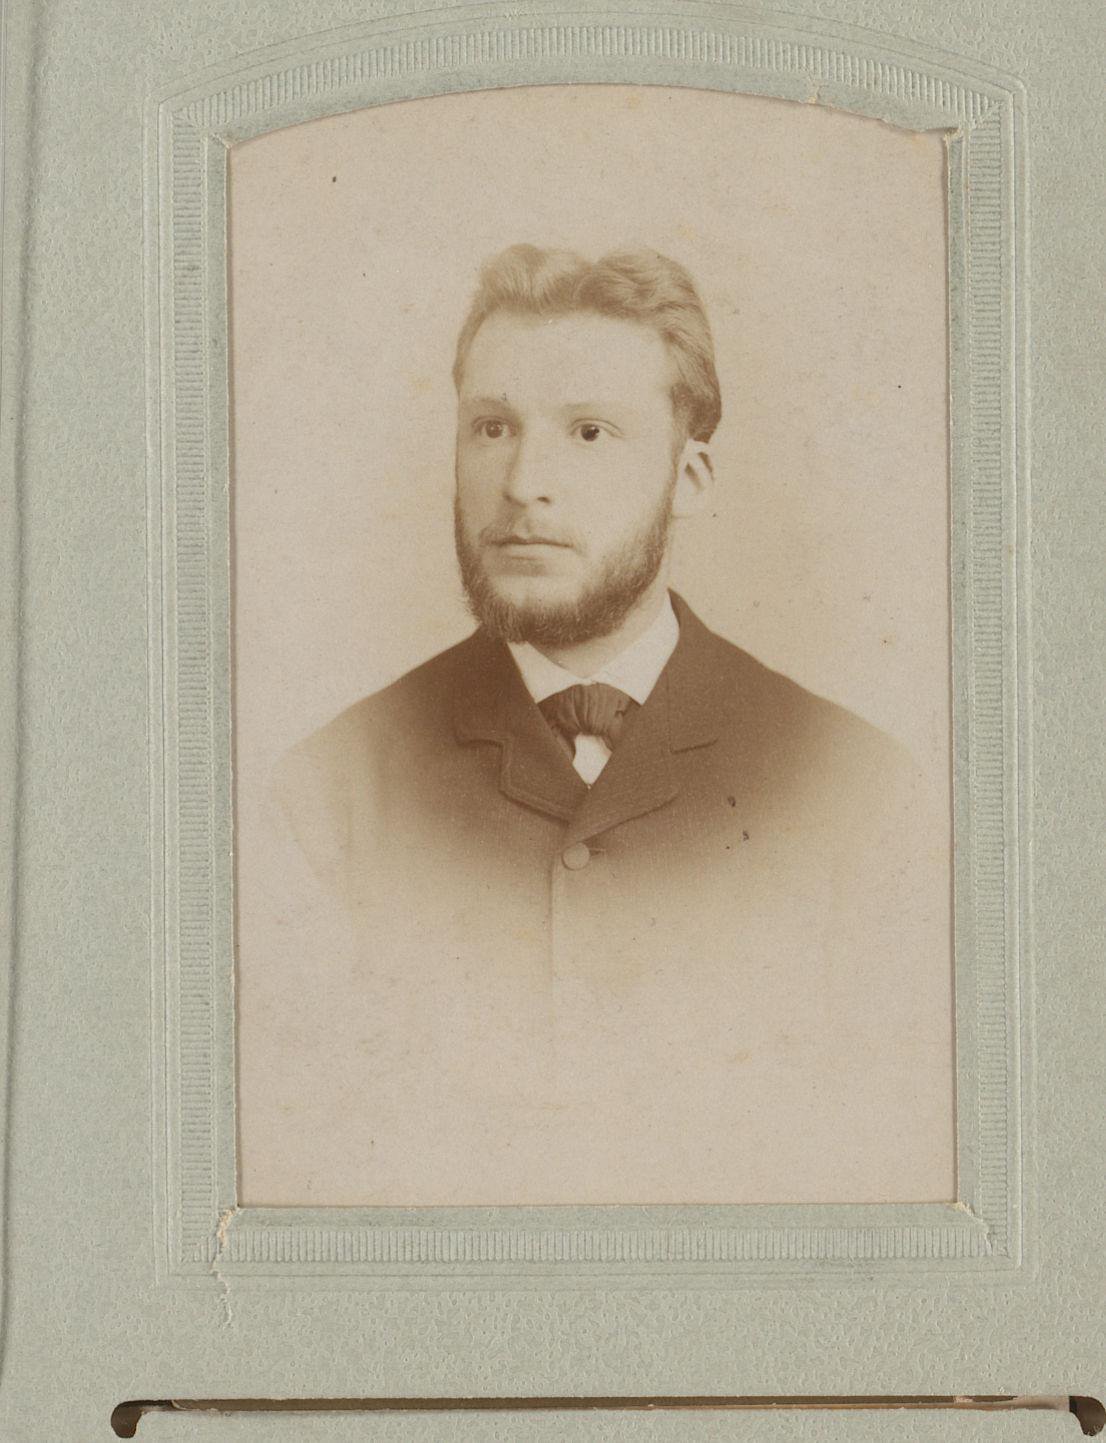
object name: photograph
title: Portret van een man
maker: max büttinghausen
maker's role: fotograaf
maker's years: 1847-1906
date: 1890-1910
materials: cardboard, photographic support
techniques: albumen print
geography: amsterdam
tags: adult man, historical persons